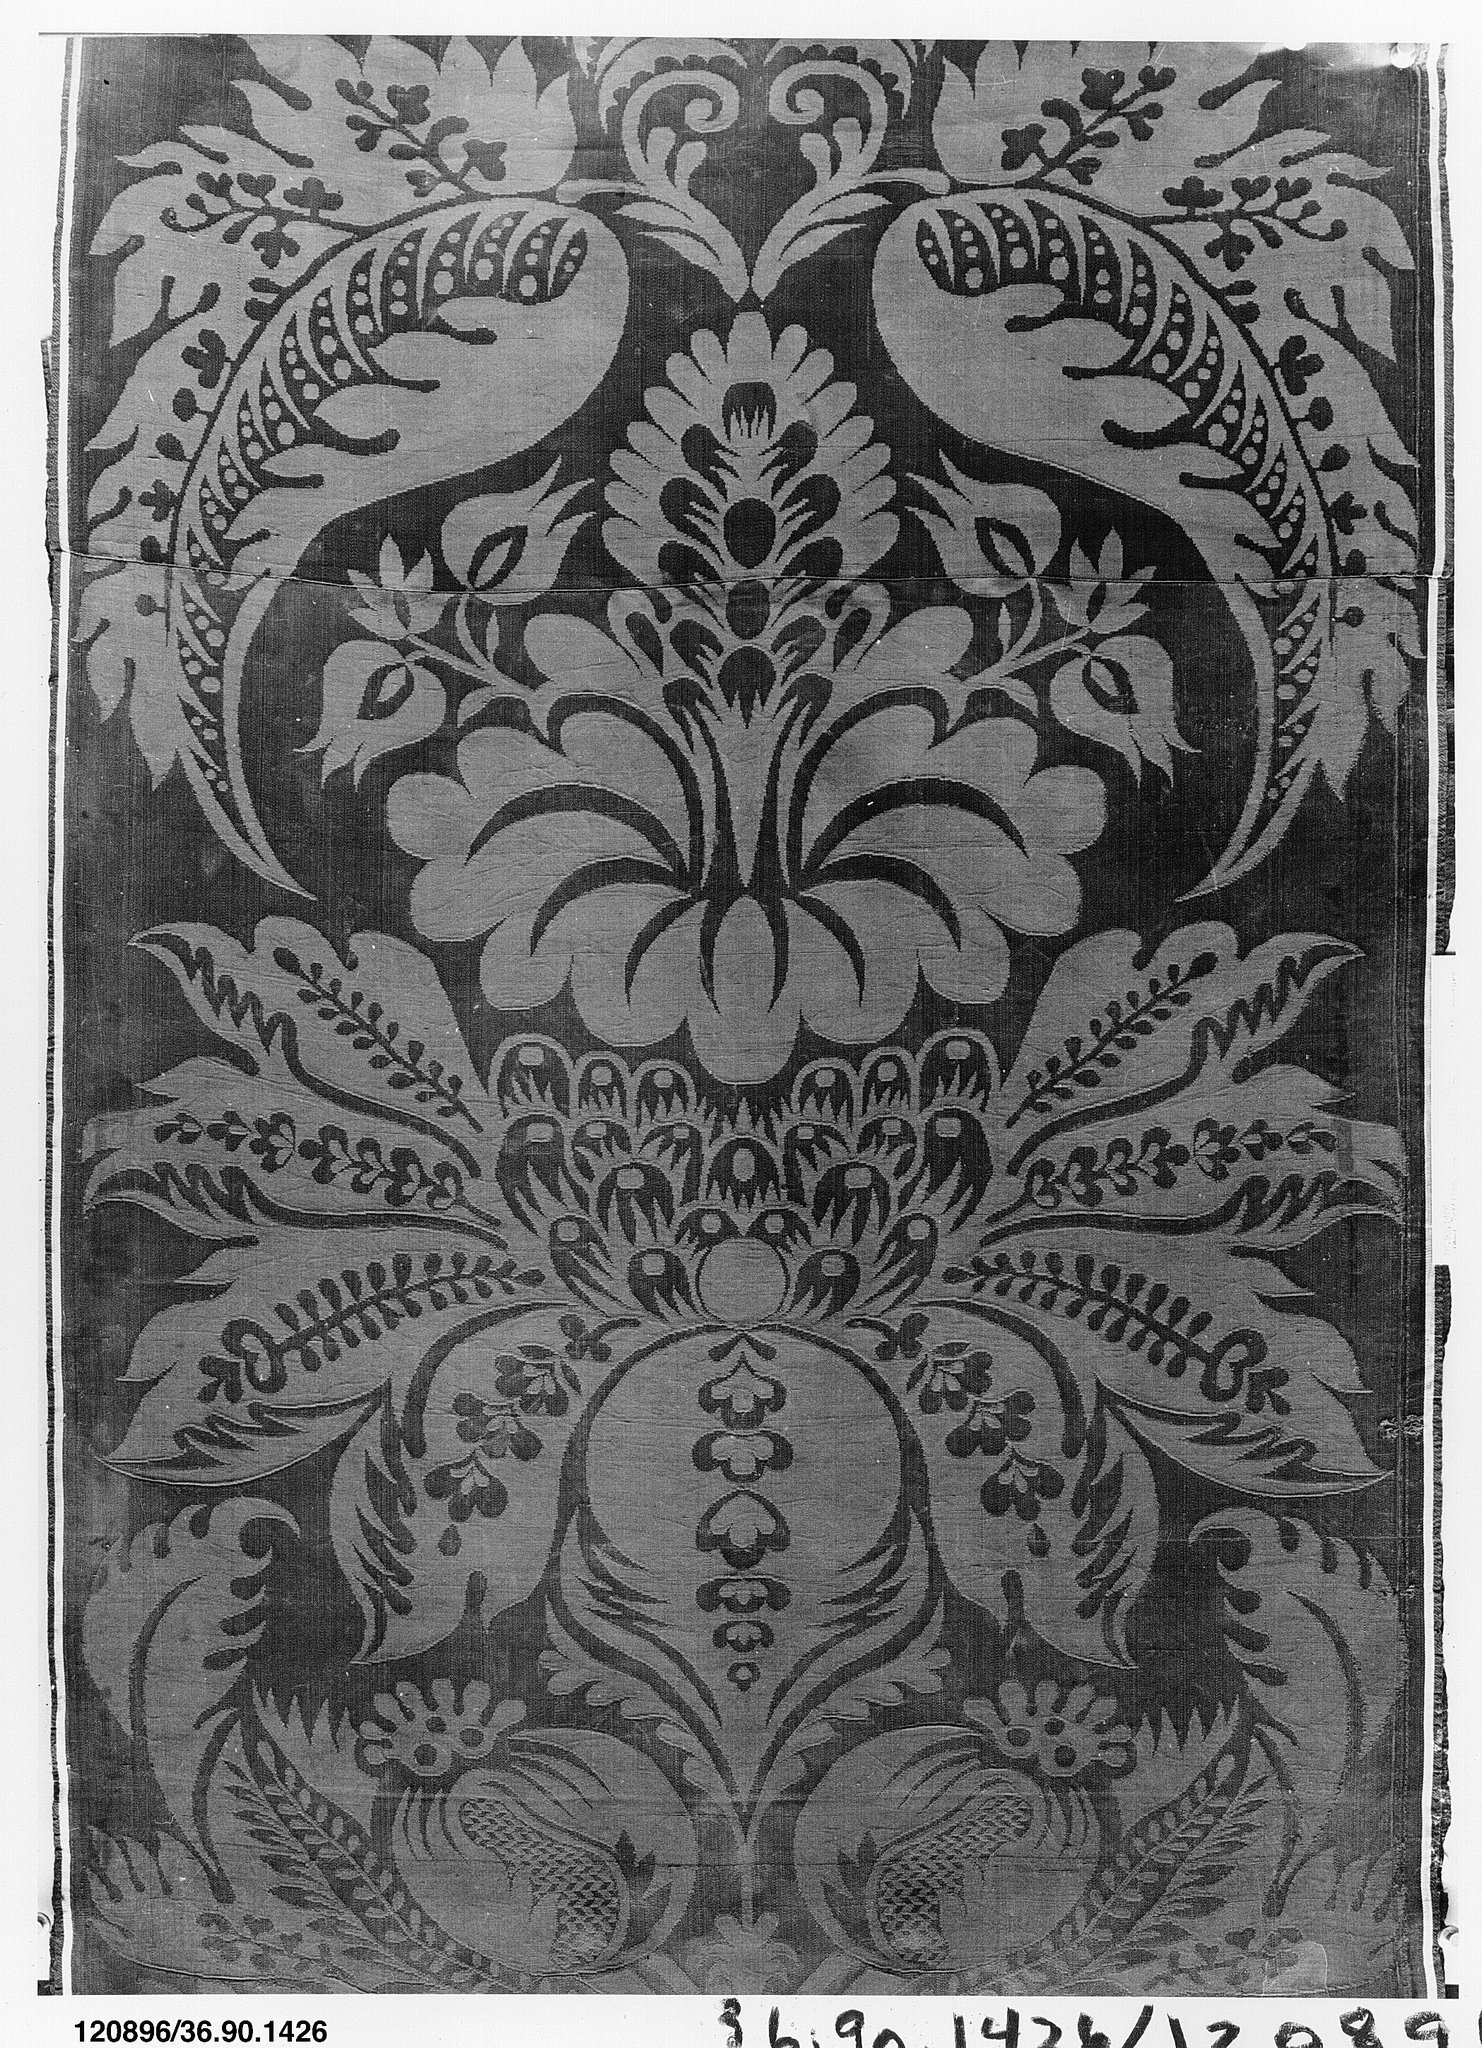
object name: piece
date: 1730-1760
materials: silk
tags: flowers